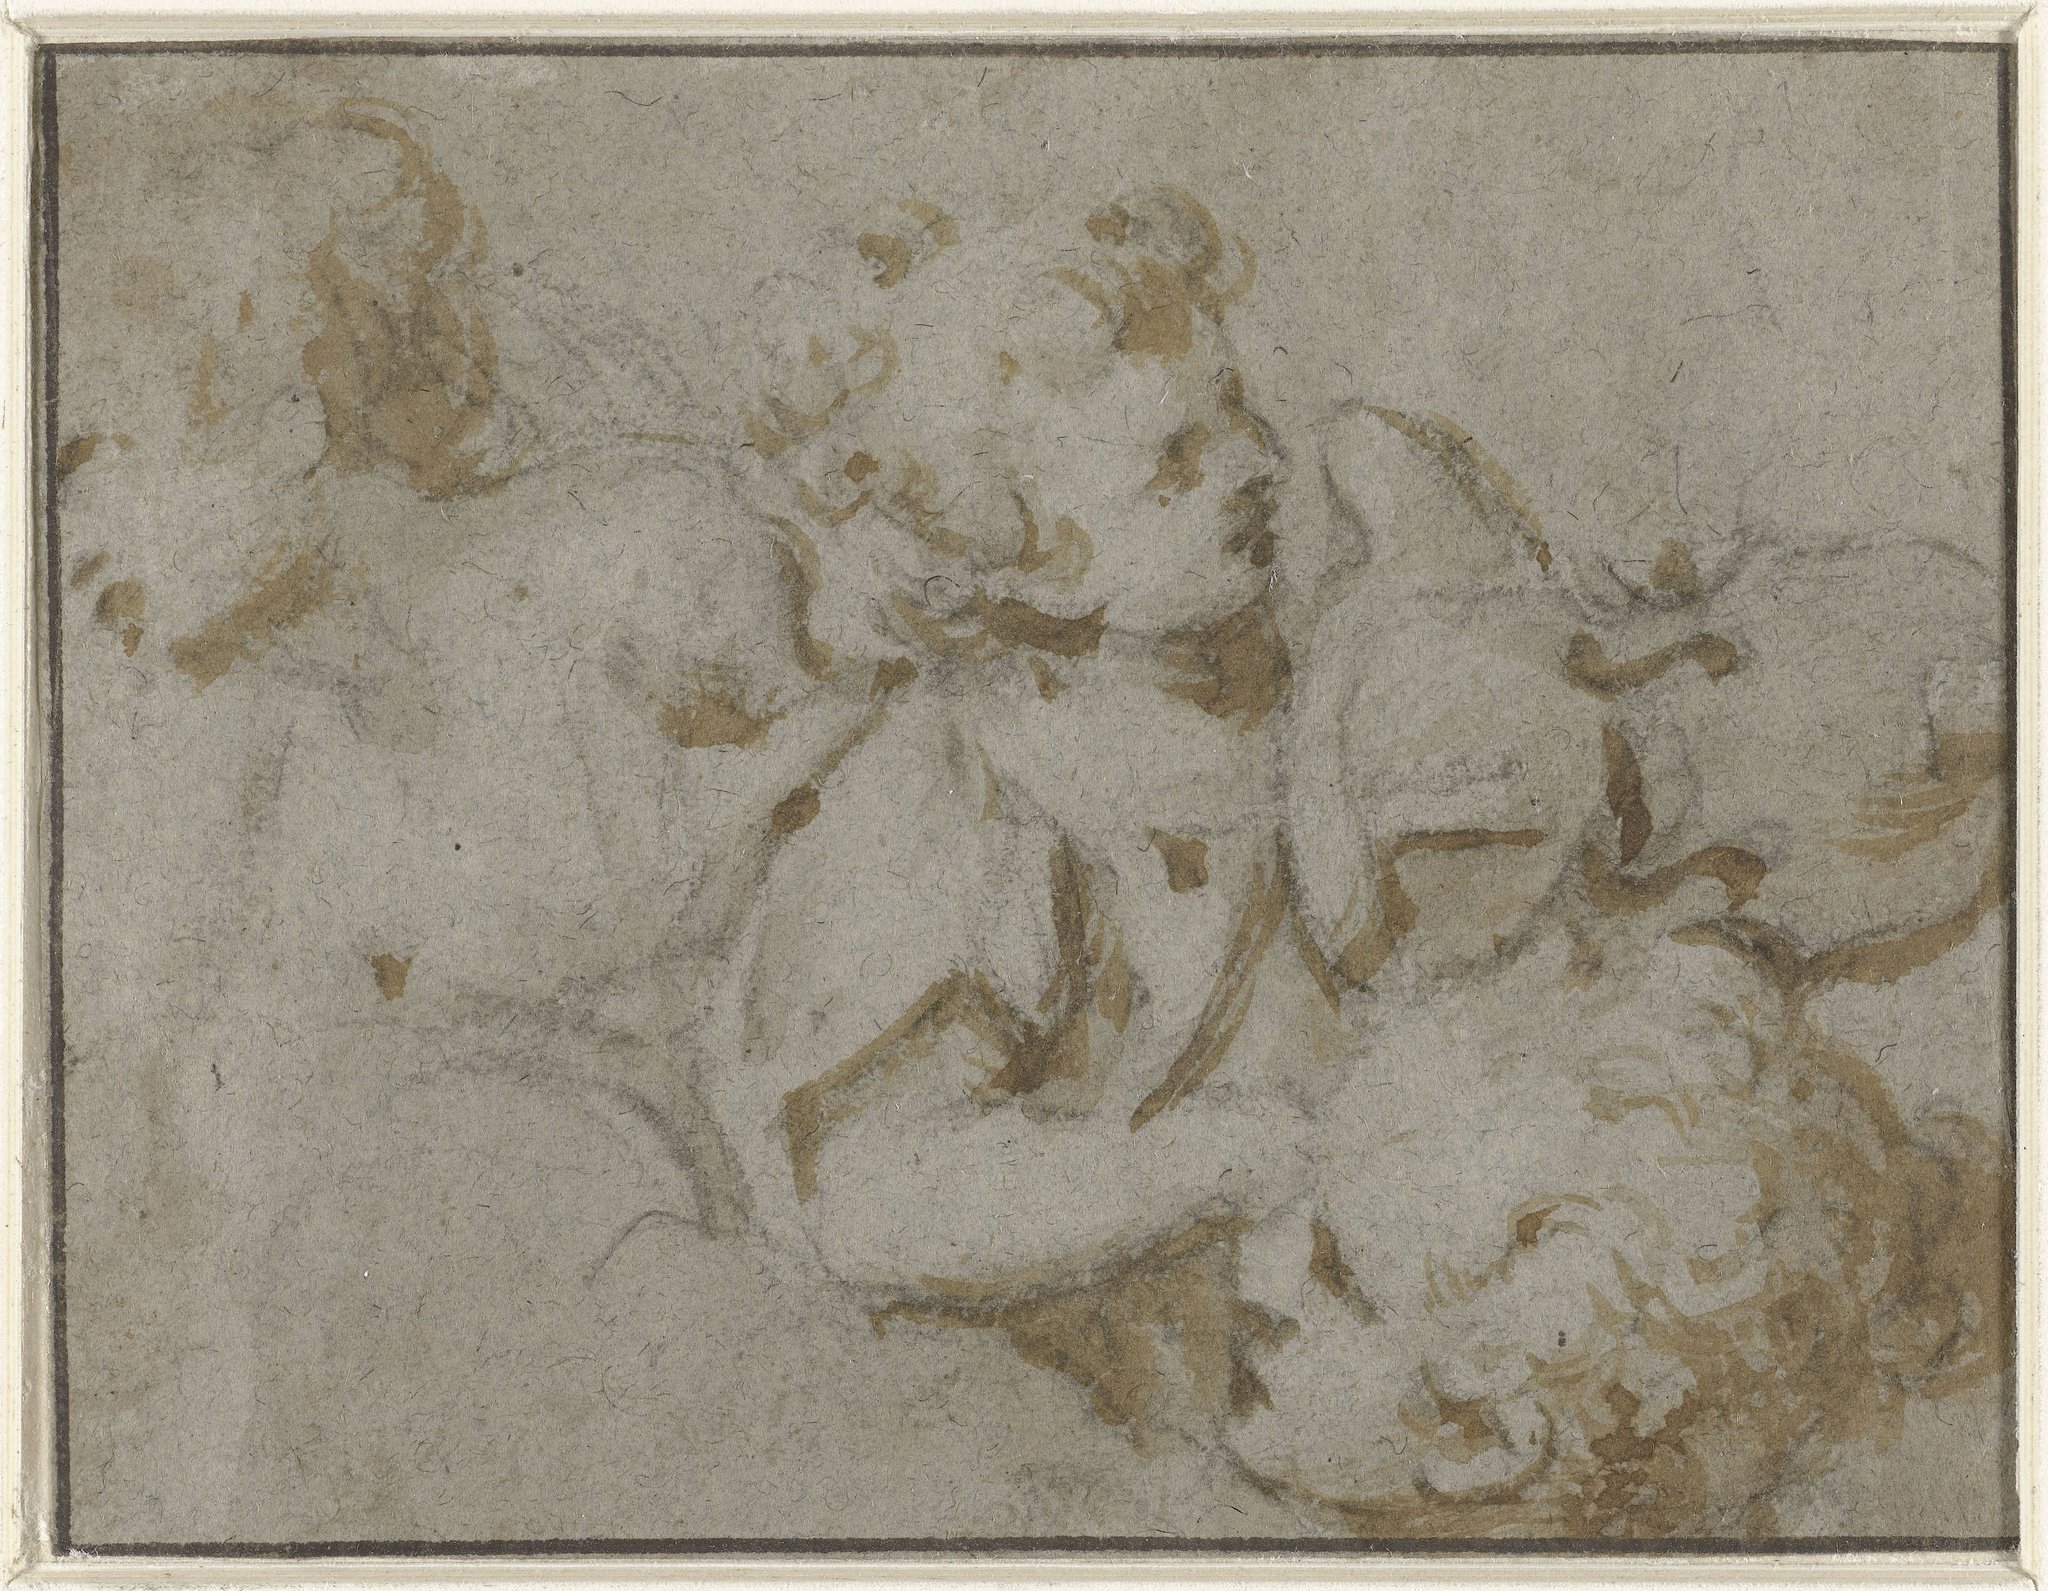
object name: drawing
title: Hoofden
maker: schiavone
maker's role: draughtsman, painter, print maker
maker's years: 1500-1563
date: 1520-1563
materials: chalk, paper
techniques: brush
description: Hoofden, waaronder één van een vioolspelende engel, uitstekend boven een wolkenrand.